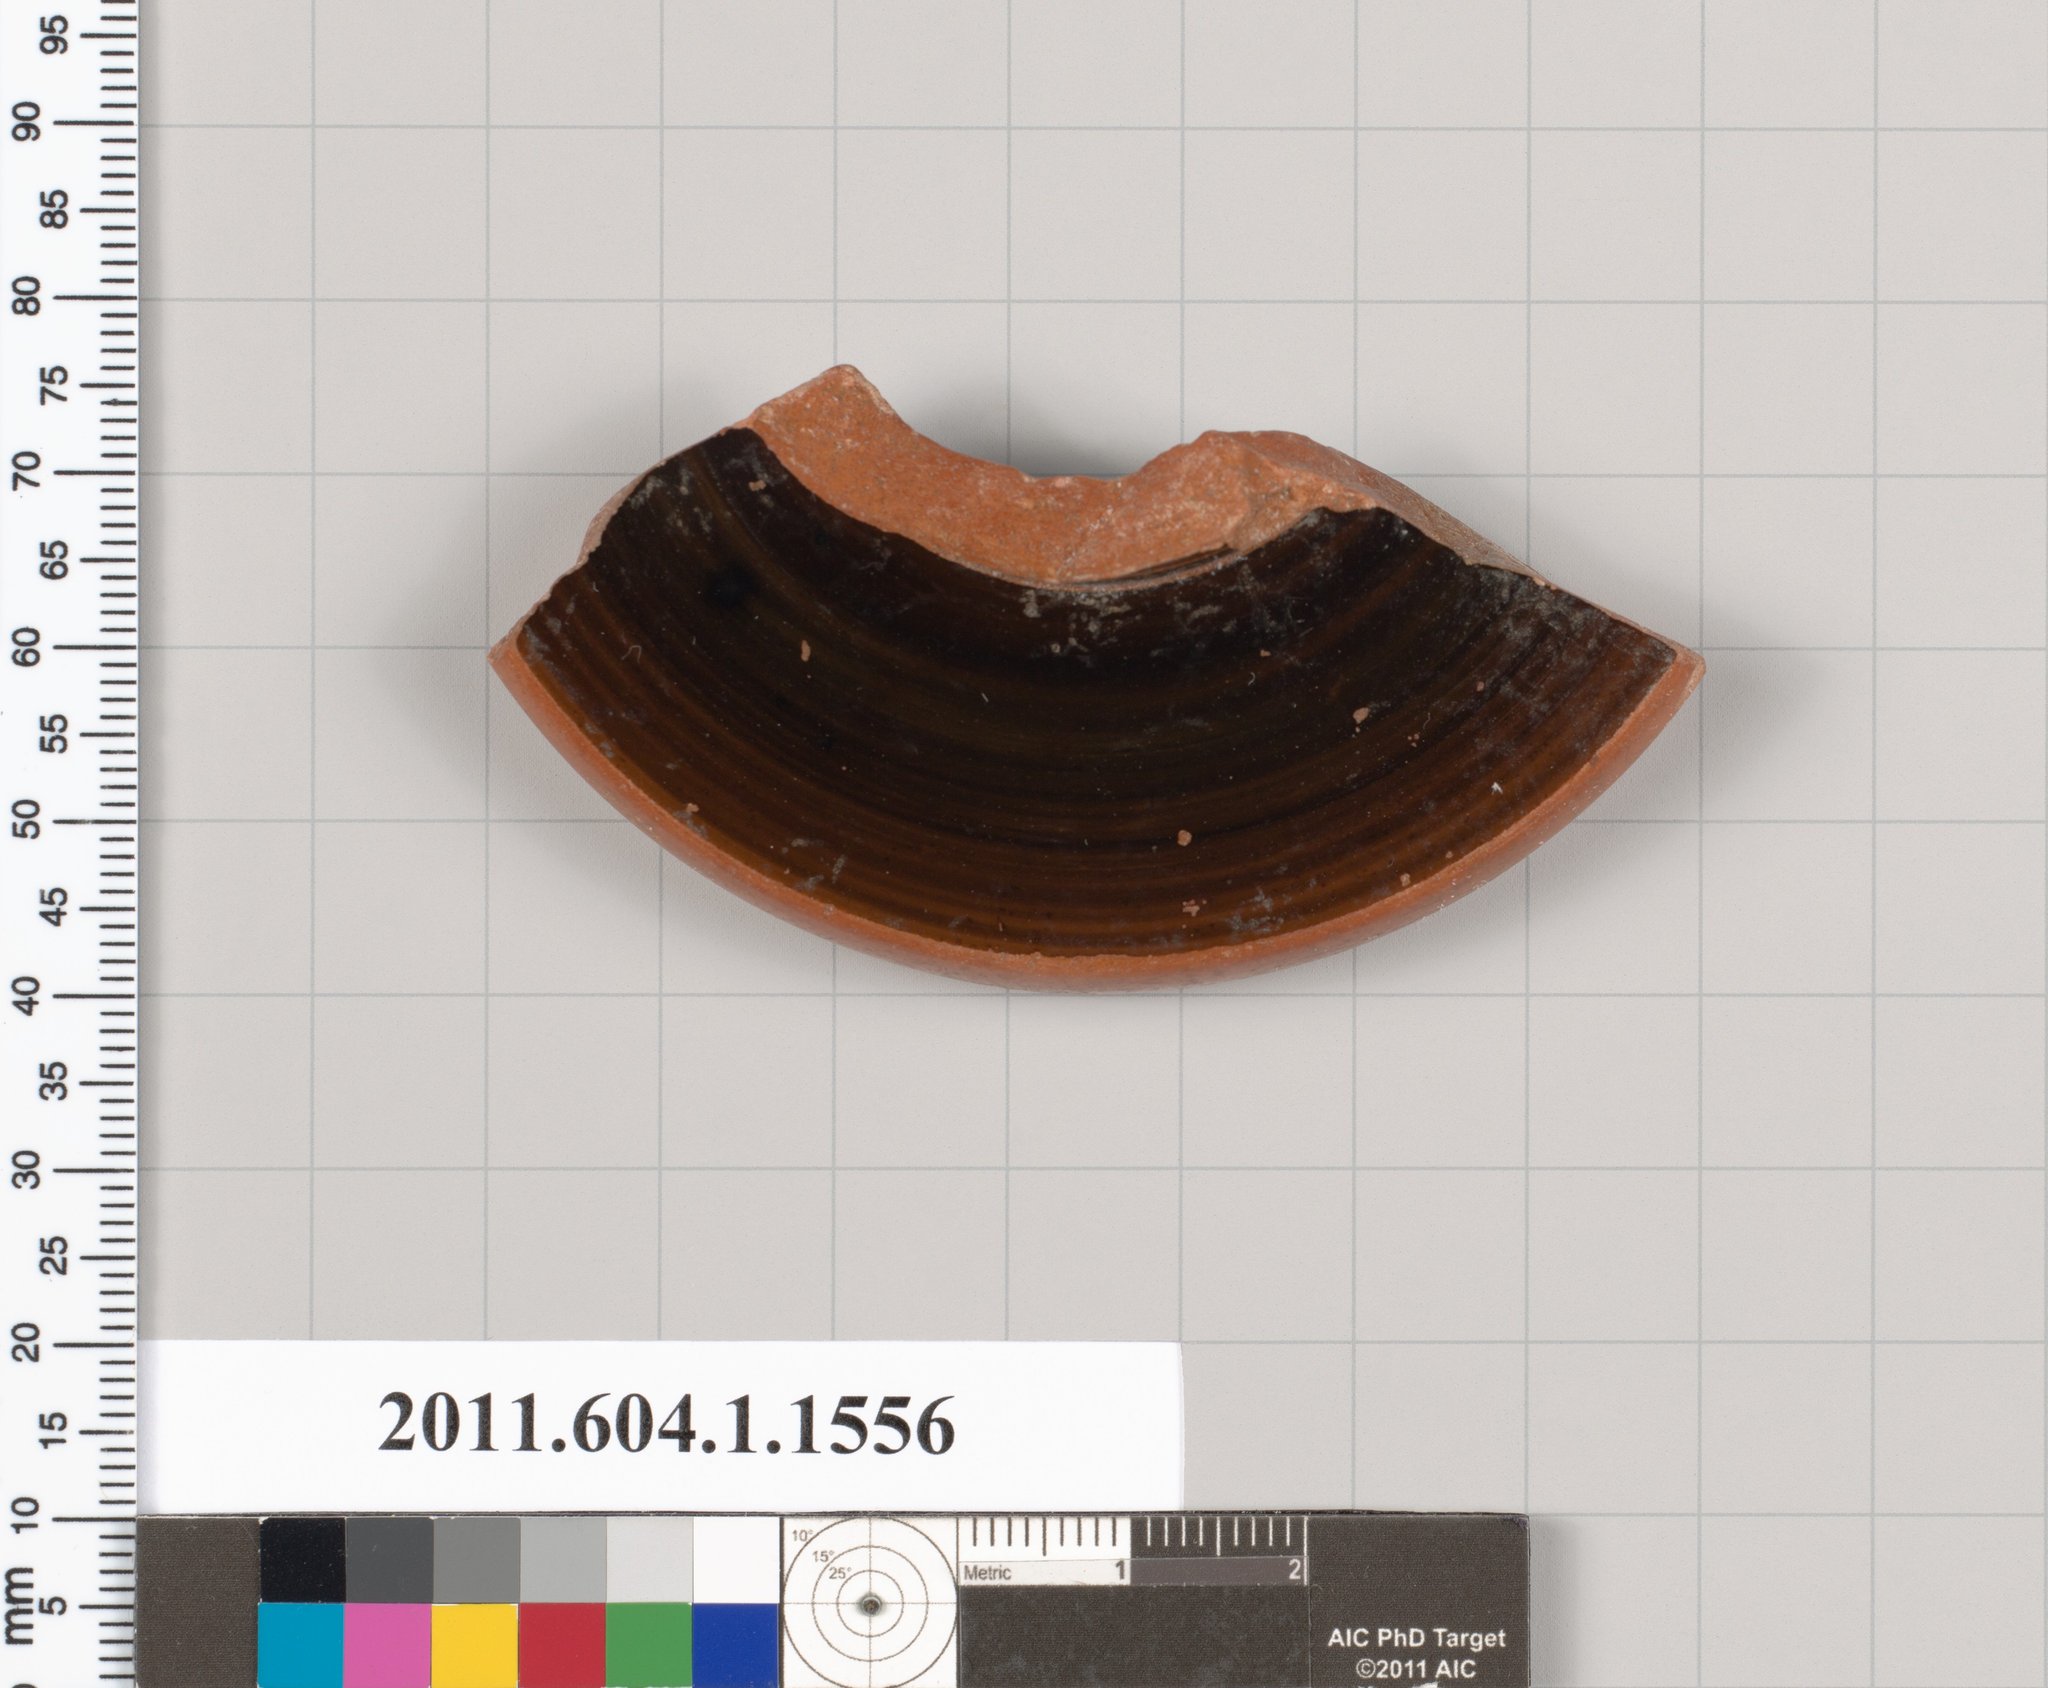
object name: kylix fragment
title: Terracotta fragment of a kylix (drinking cup)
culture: greek, attic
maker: pithos painter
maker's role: artist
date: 534-501 BCE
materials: terracotta